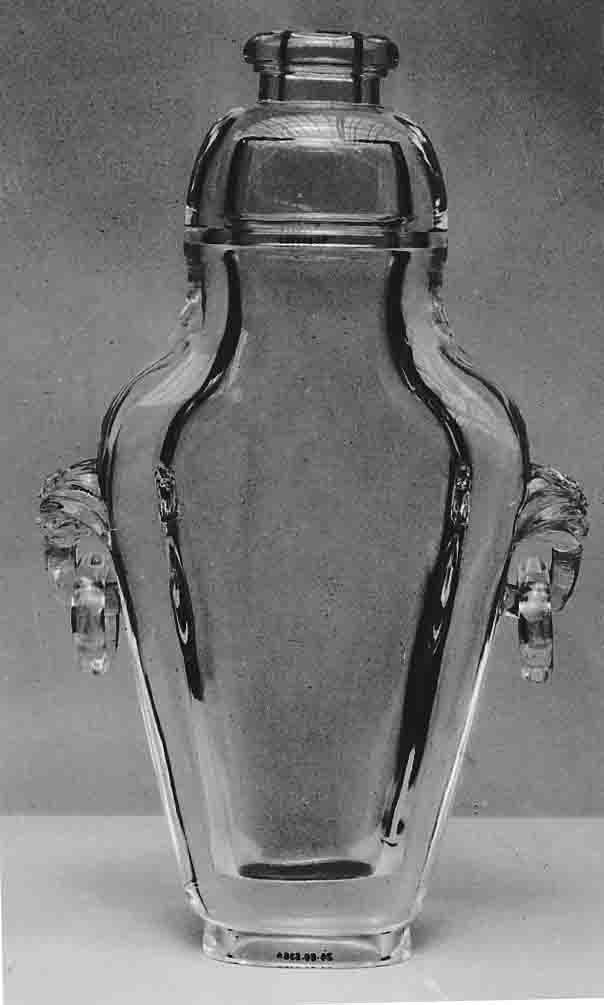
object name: covered vase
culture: chinese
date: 1801-1900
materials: quartz